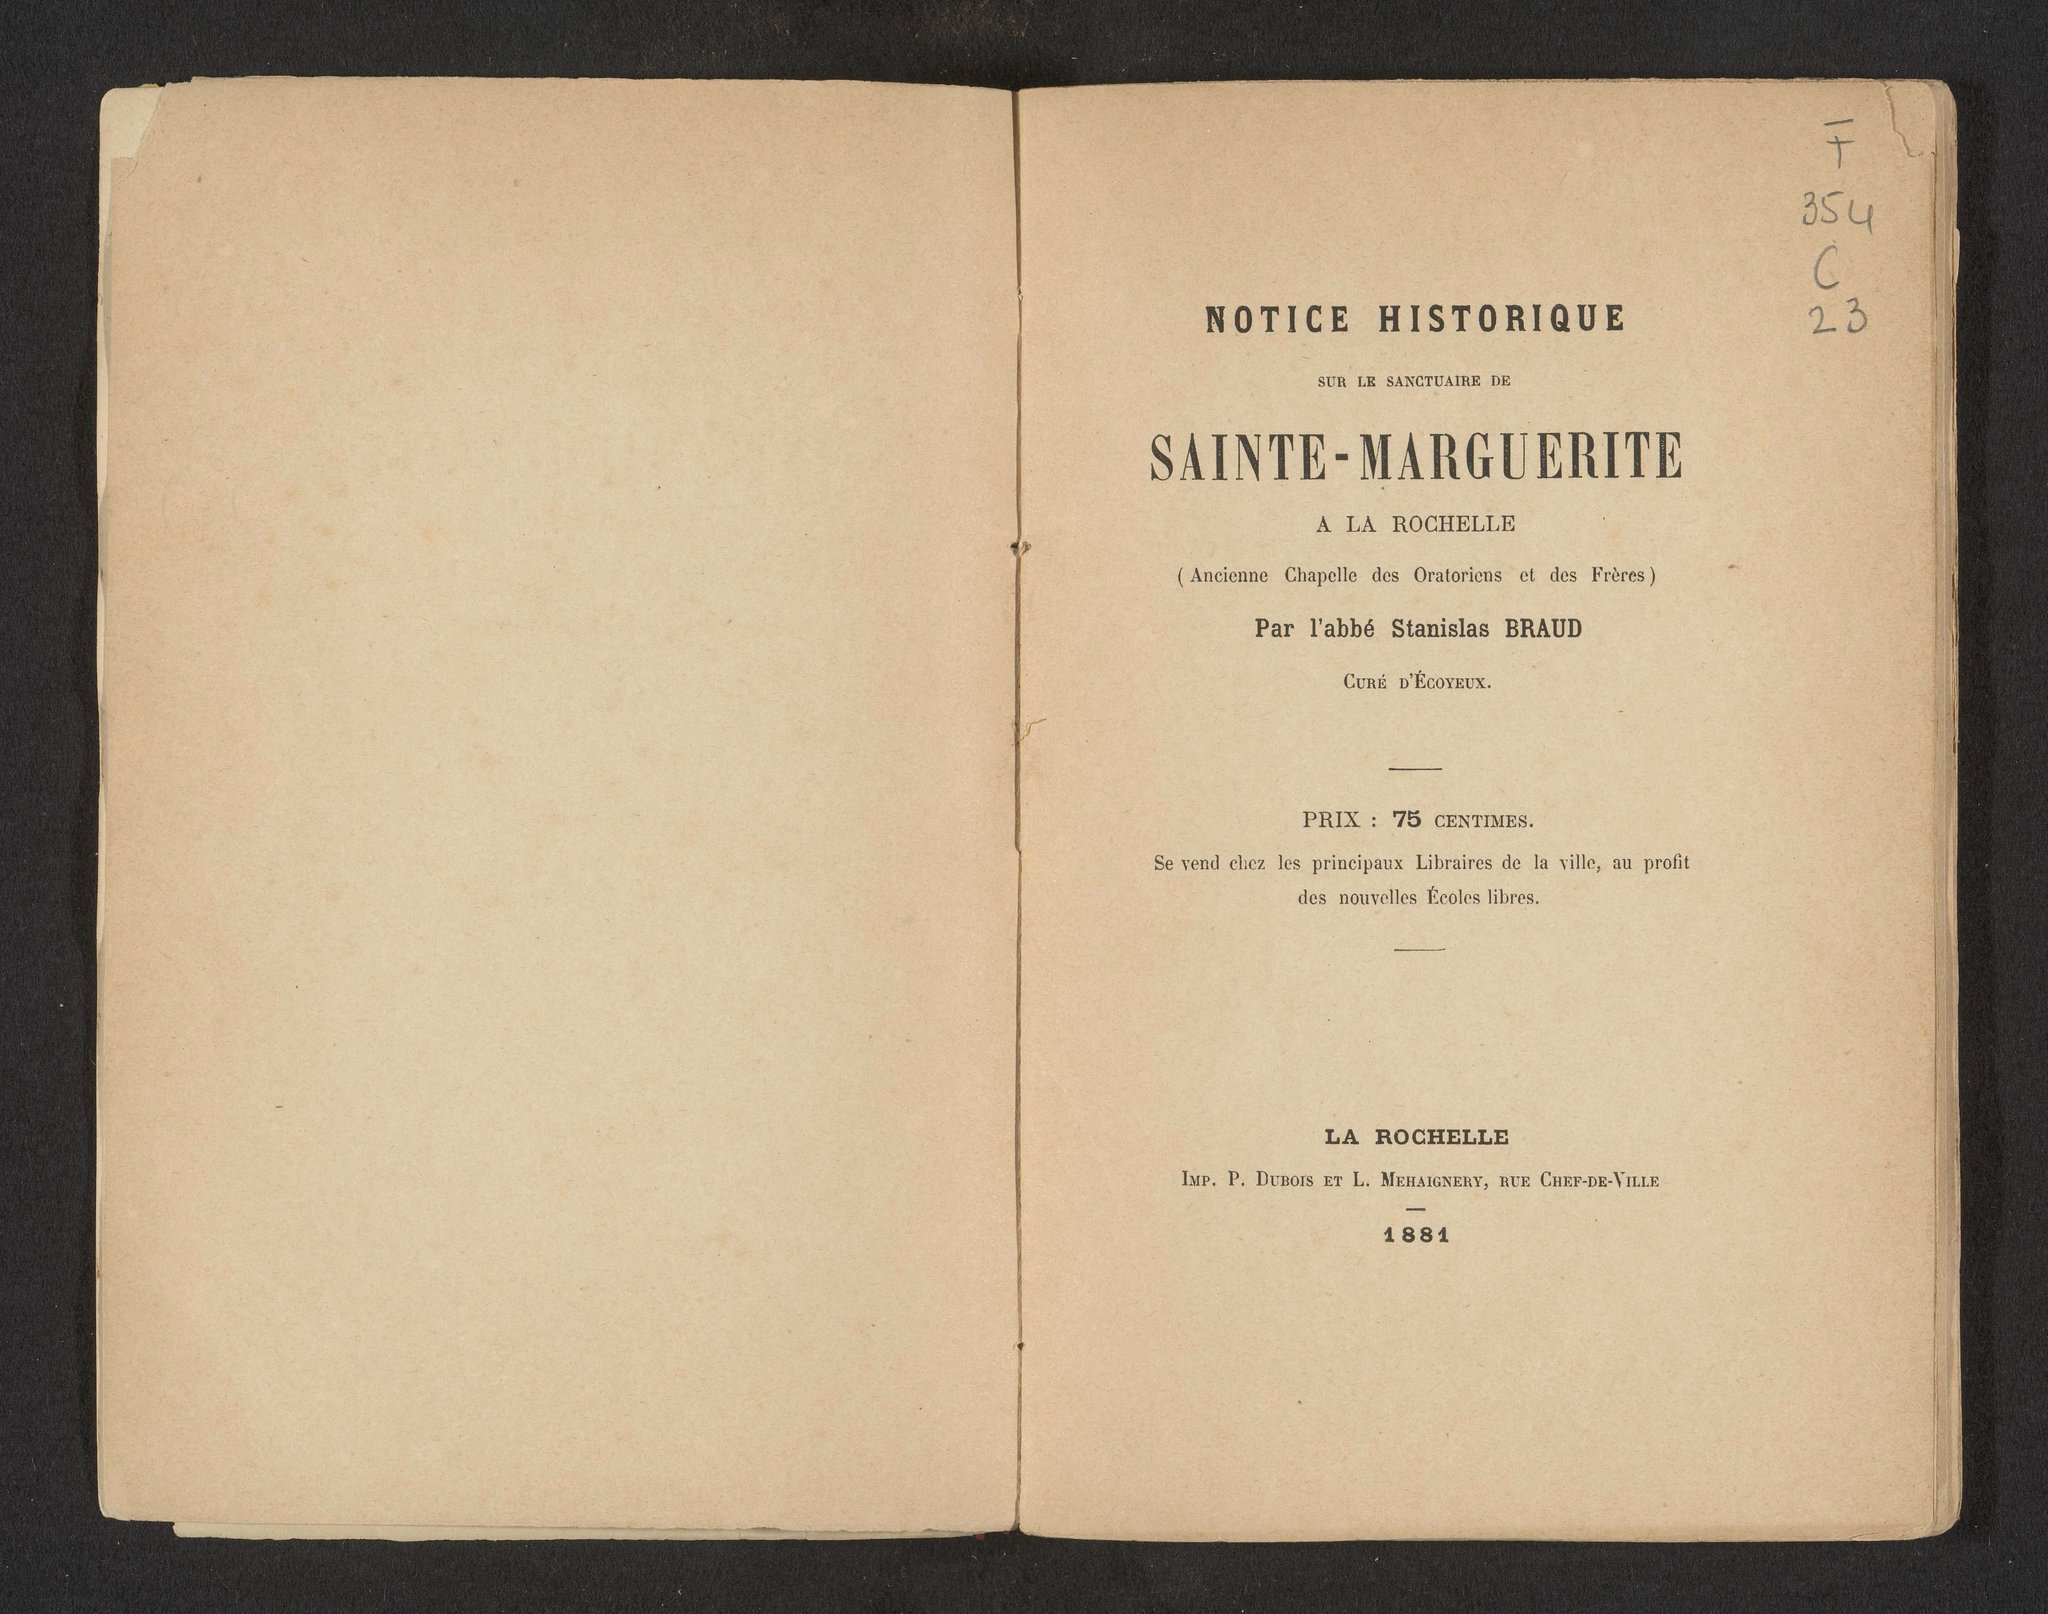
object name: book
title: Notice historique sur le sanctuaire de Sainte-Marguerite à La Rochelle (ancienne Chapelle des Oratoriens et des Frères)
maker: stanislas braud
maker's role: abt, dichter, schrijver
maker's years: 1838-1885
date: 1881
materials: paper, photographic support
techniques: albumen print, printing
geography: la rochelle